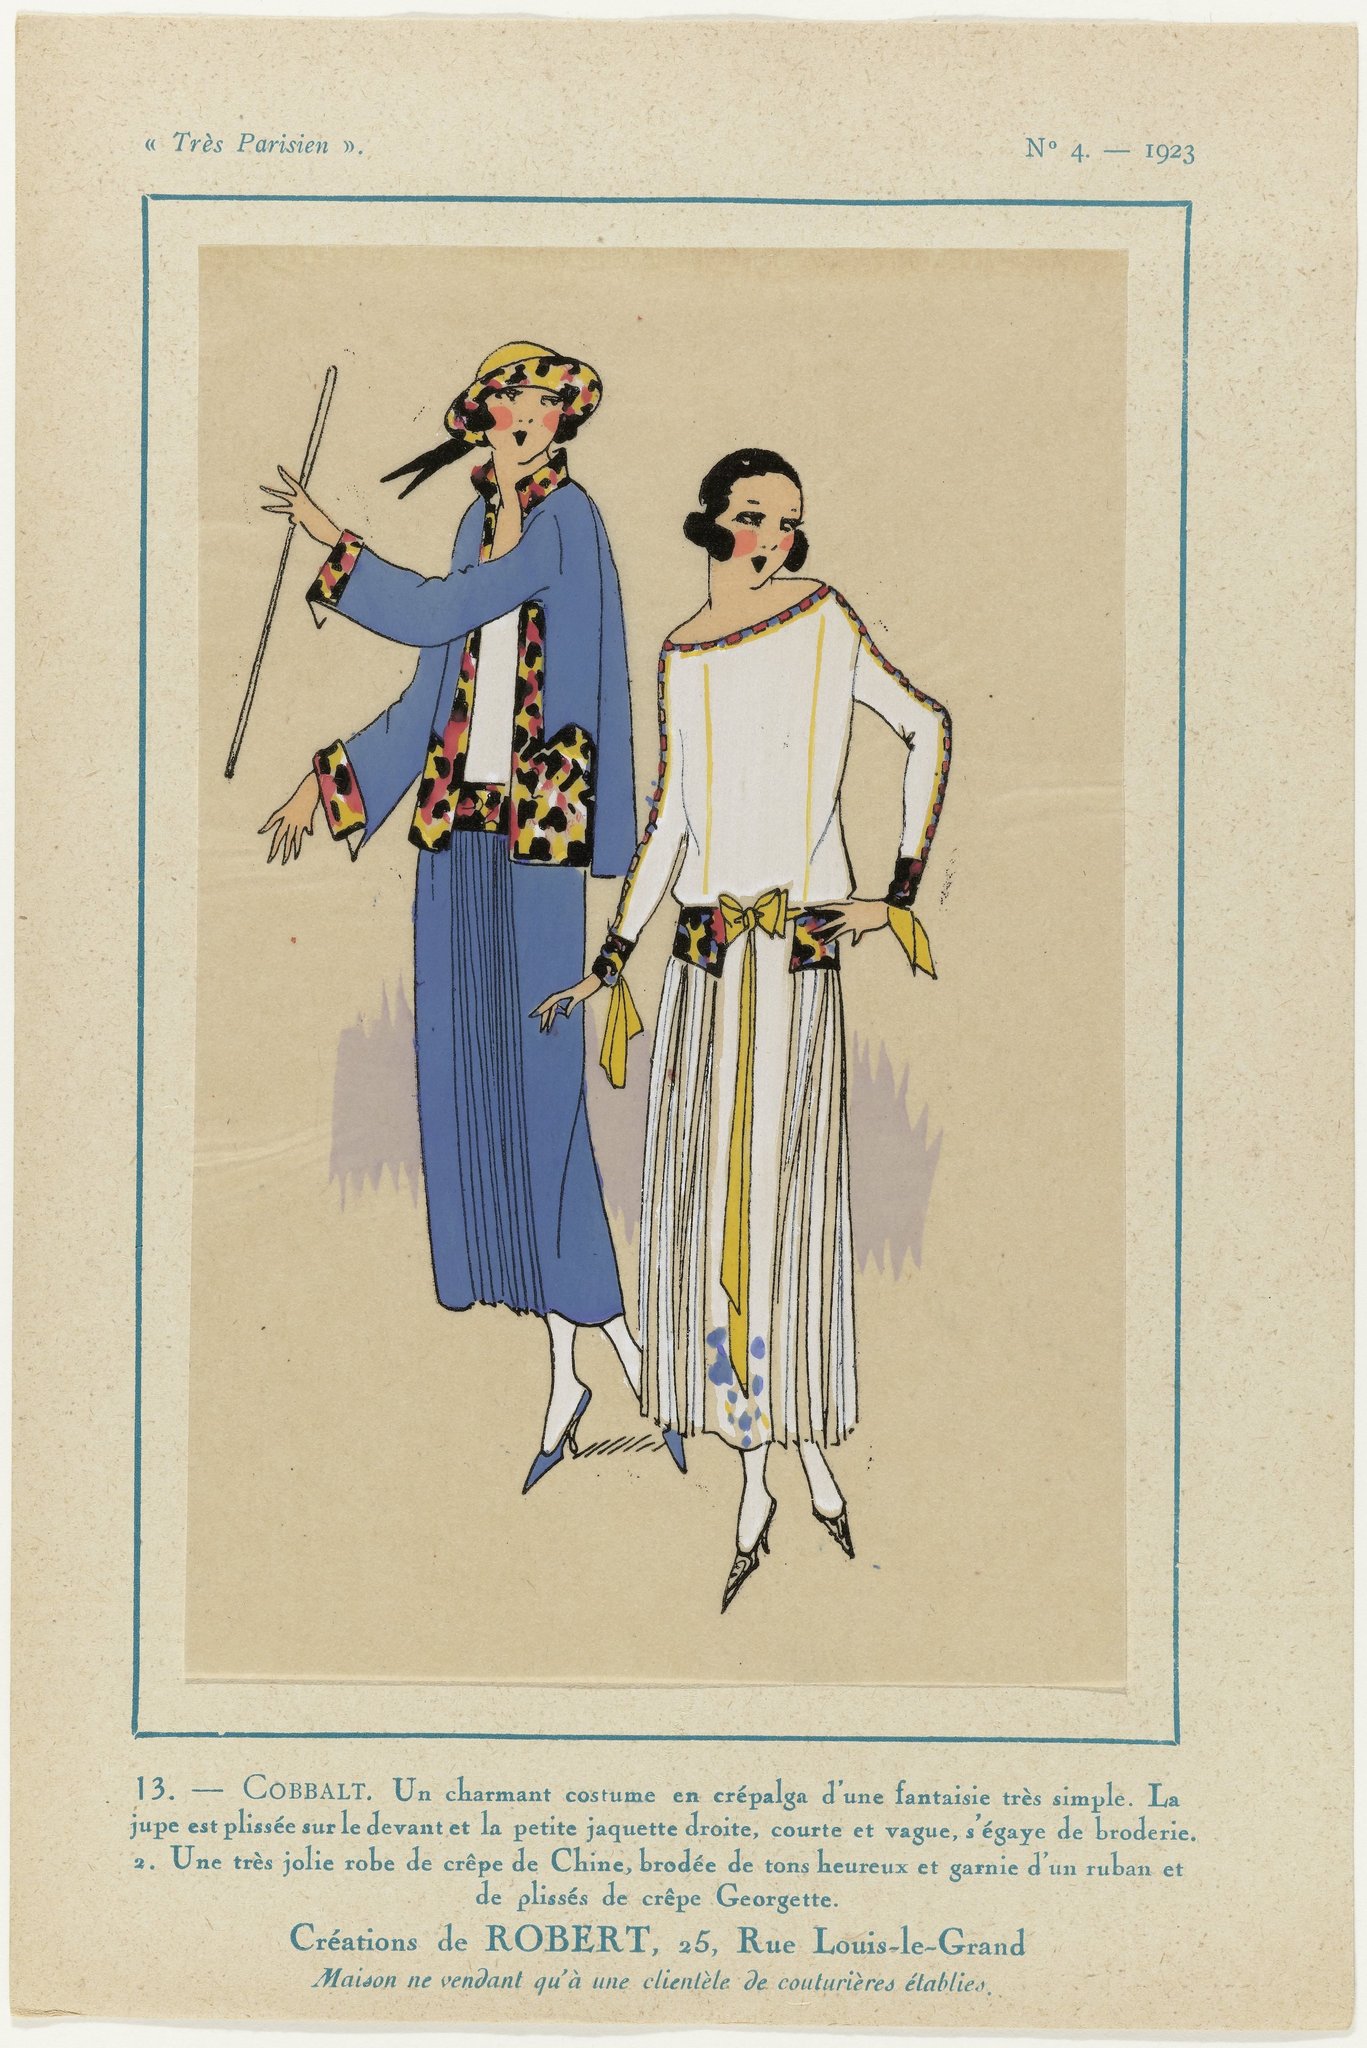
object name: fashion print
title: Très Parisien, 1923, No. 4: 13. - COBBALT. Un charmant costume...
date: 1923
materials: paper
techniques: hand coloring, letterpress printing, lithography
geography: paris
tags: walking-stick, staff, cane (+ women's clothes), embroidery (ornamentation) (+ women's clothes), border, ribbon, braid (+ women's clothes), ensembles of pieces of clothing (suit) (+ women's clothes), fashion plates, head-gear: hat (+ women's clothes), skirt (+ women's clothes), dress, gown (+ women's clothes)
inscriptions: title: ‘Très Parisien / No 4. - 1923’, caption: ‘13. - COBBALT. Un charmant costume en crépalga d'une fantaisie très simple. La jupe est plissée sur le devant et la petite jaquette droite, courte et vague, s'égaye de broderie. 2. Une très jolie robe de crêpe de Chine, brodée de tons heureux et garnie d'un ruban et de plissés, de crêpe Georgette. / Créations de ROBERT, 25, Rue Louis-le -Grand / Maison ne vendant qu'à une clientèle de couturières établies.’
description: 1. Een eenvoudig kostuum (mantelpak) van 'crépalga'. De rok is middenvoor geplisseerd; jas, kort en recht model, versierd met borduurwerk. 2. Jurk van crêpe de Chine, geborduurd in verschillende kleuren en gegarneerd met een lint en plooien van crêpe Georgette. Ontwerpen van Robert. Prent uit het modetijdschrift Très Parisien (1920-1936).